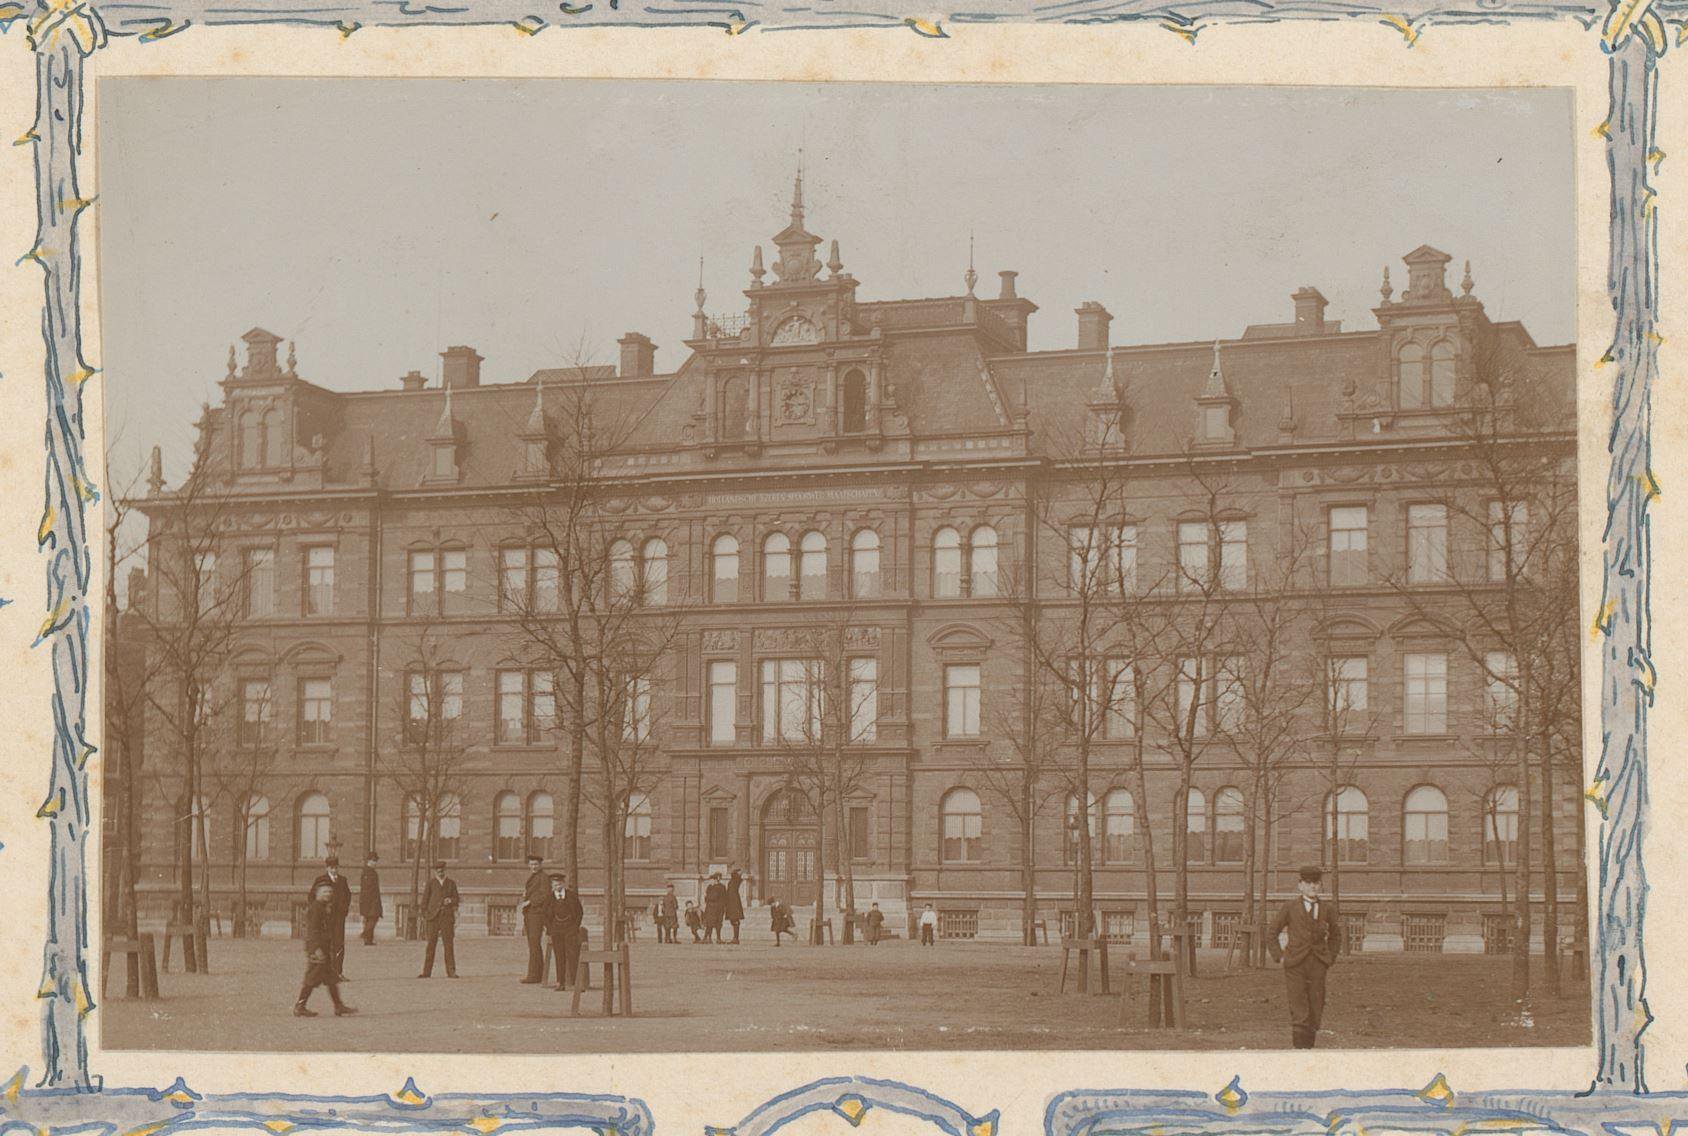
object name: album leaf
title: Gezicht op het administratiekantoor van de Hollandsche IJzeren Spoorweg-Maatschappij aan de Droogbak in Amsterdam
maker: j.j. reynders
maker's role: fotograaf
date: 1908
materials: cardboard, ink, photographic support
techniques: pen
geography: amsterdam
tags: railway, train, office (~ administration), amsterdam